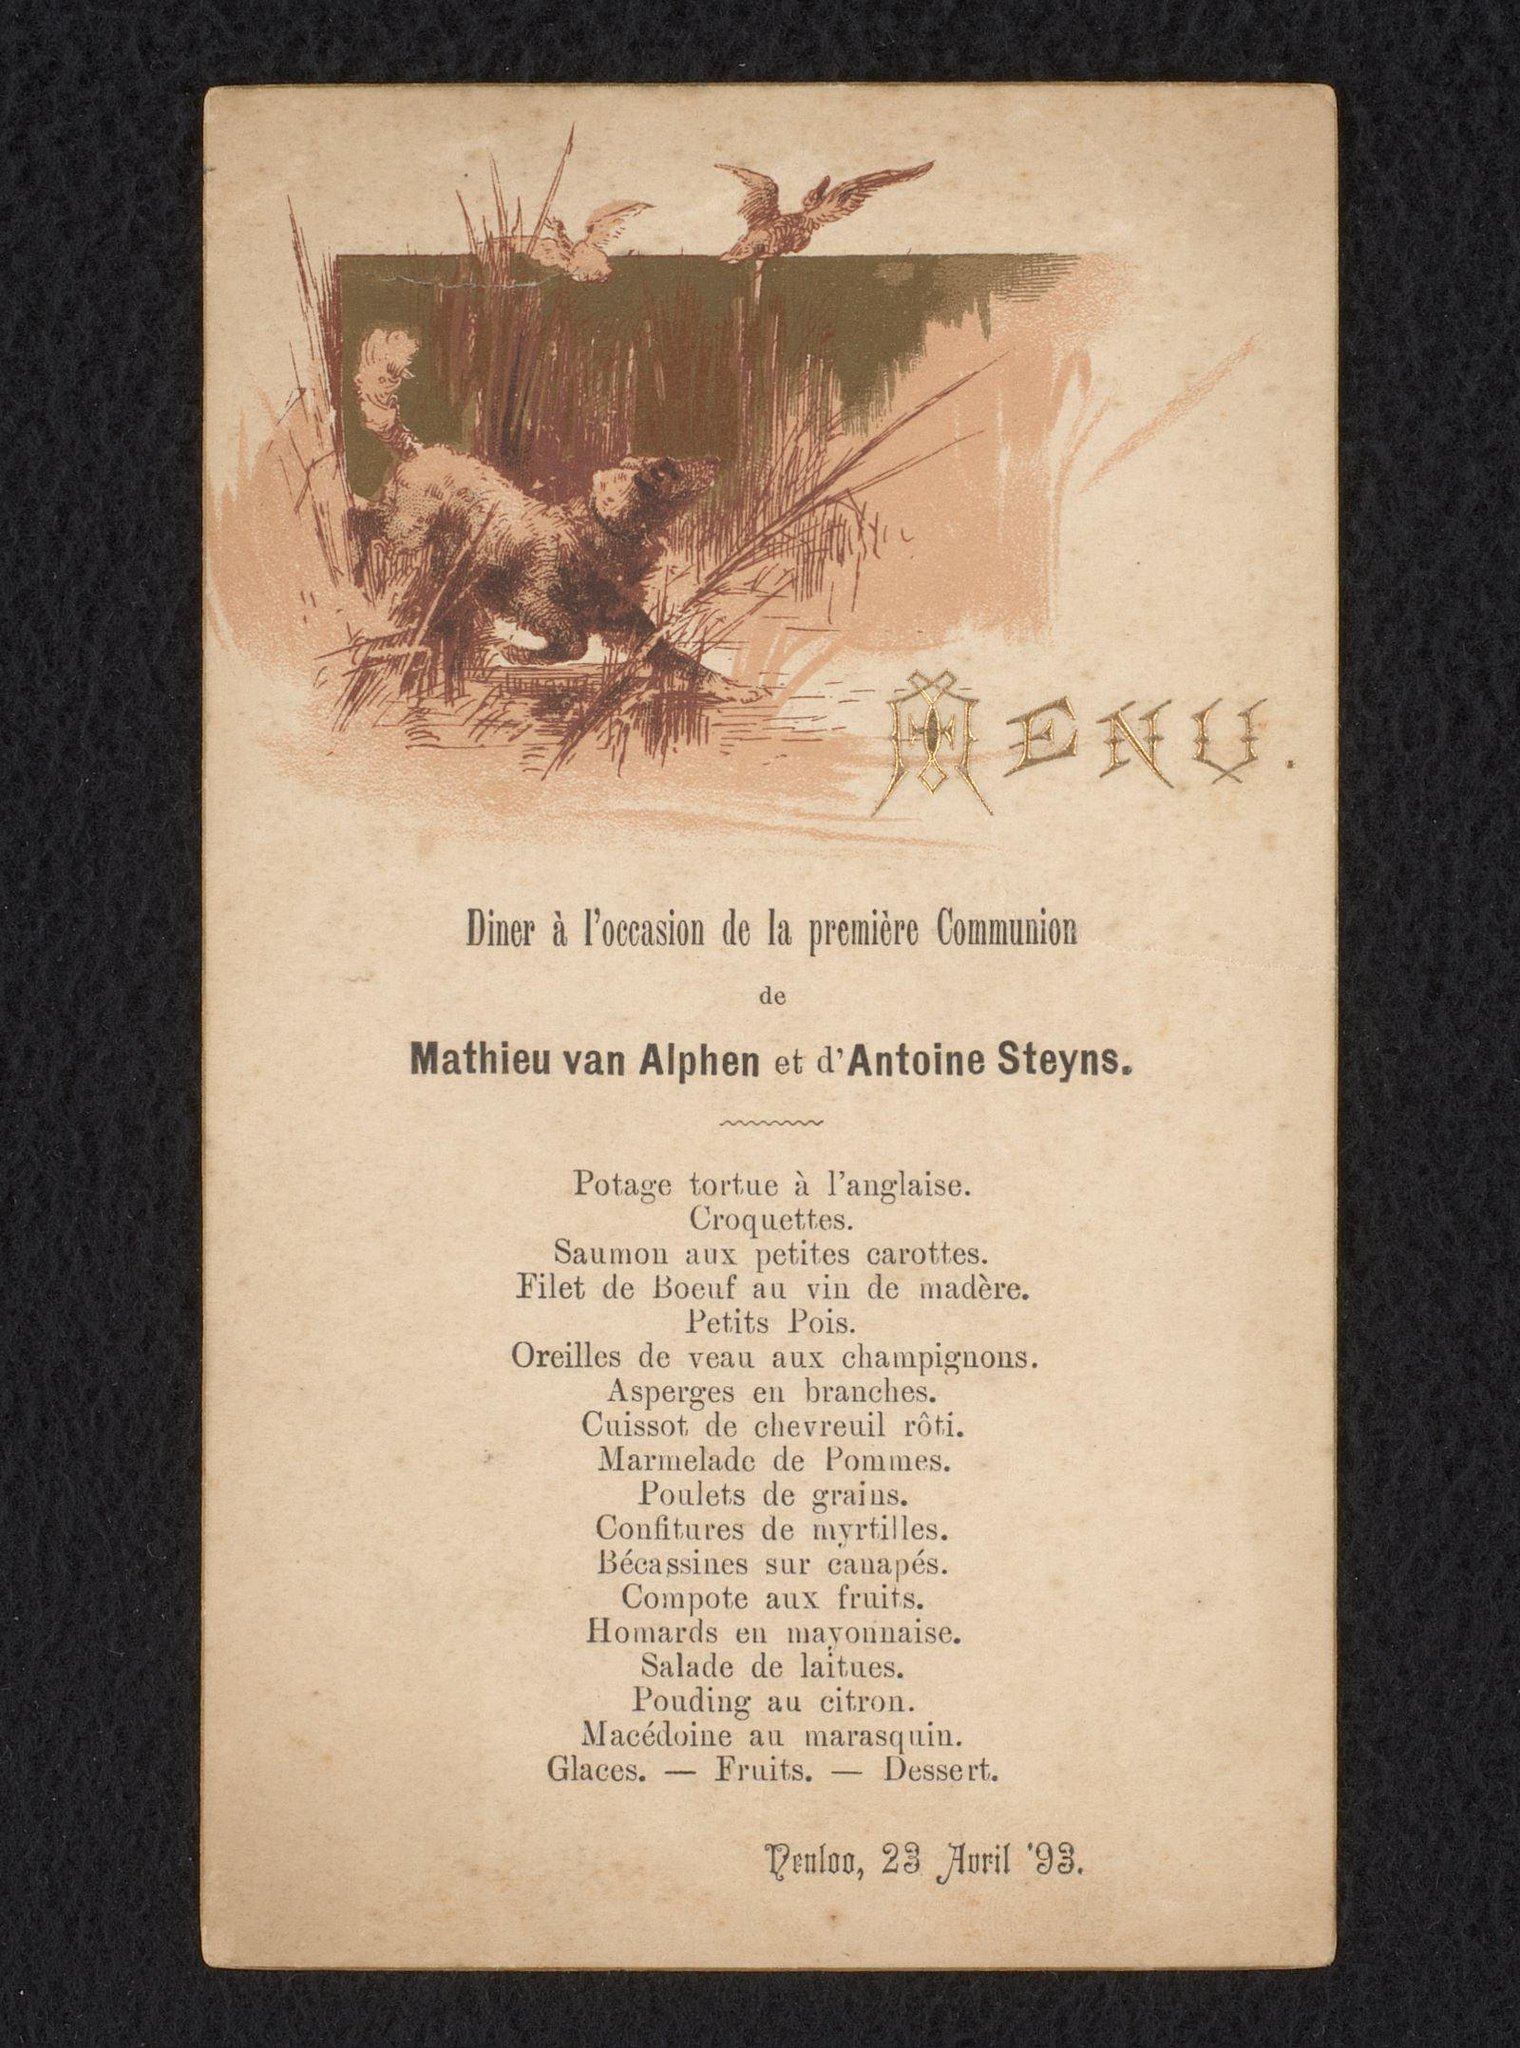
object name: print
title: Menu van het diner ter ere van de eerste heilige communie van Mathieu van Alphen en Antoine Steyns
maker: Anonymous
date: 1893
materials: paper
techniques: lithograph, letterpress printing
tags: first communion, hunting dogs, walker and runner birds: pheasant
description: Bij gebrek aan gegevens over de vervaardiger is voor de bepaling van de rechten van dit object gebruik gemaakt van de vervaardigingsdatum.